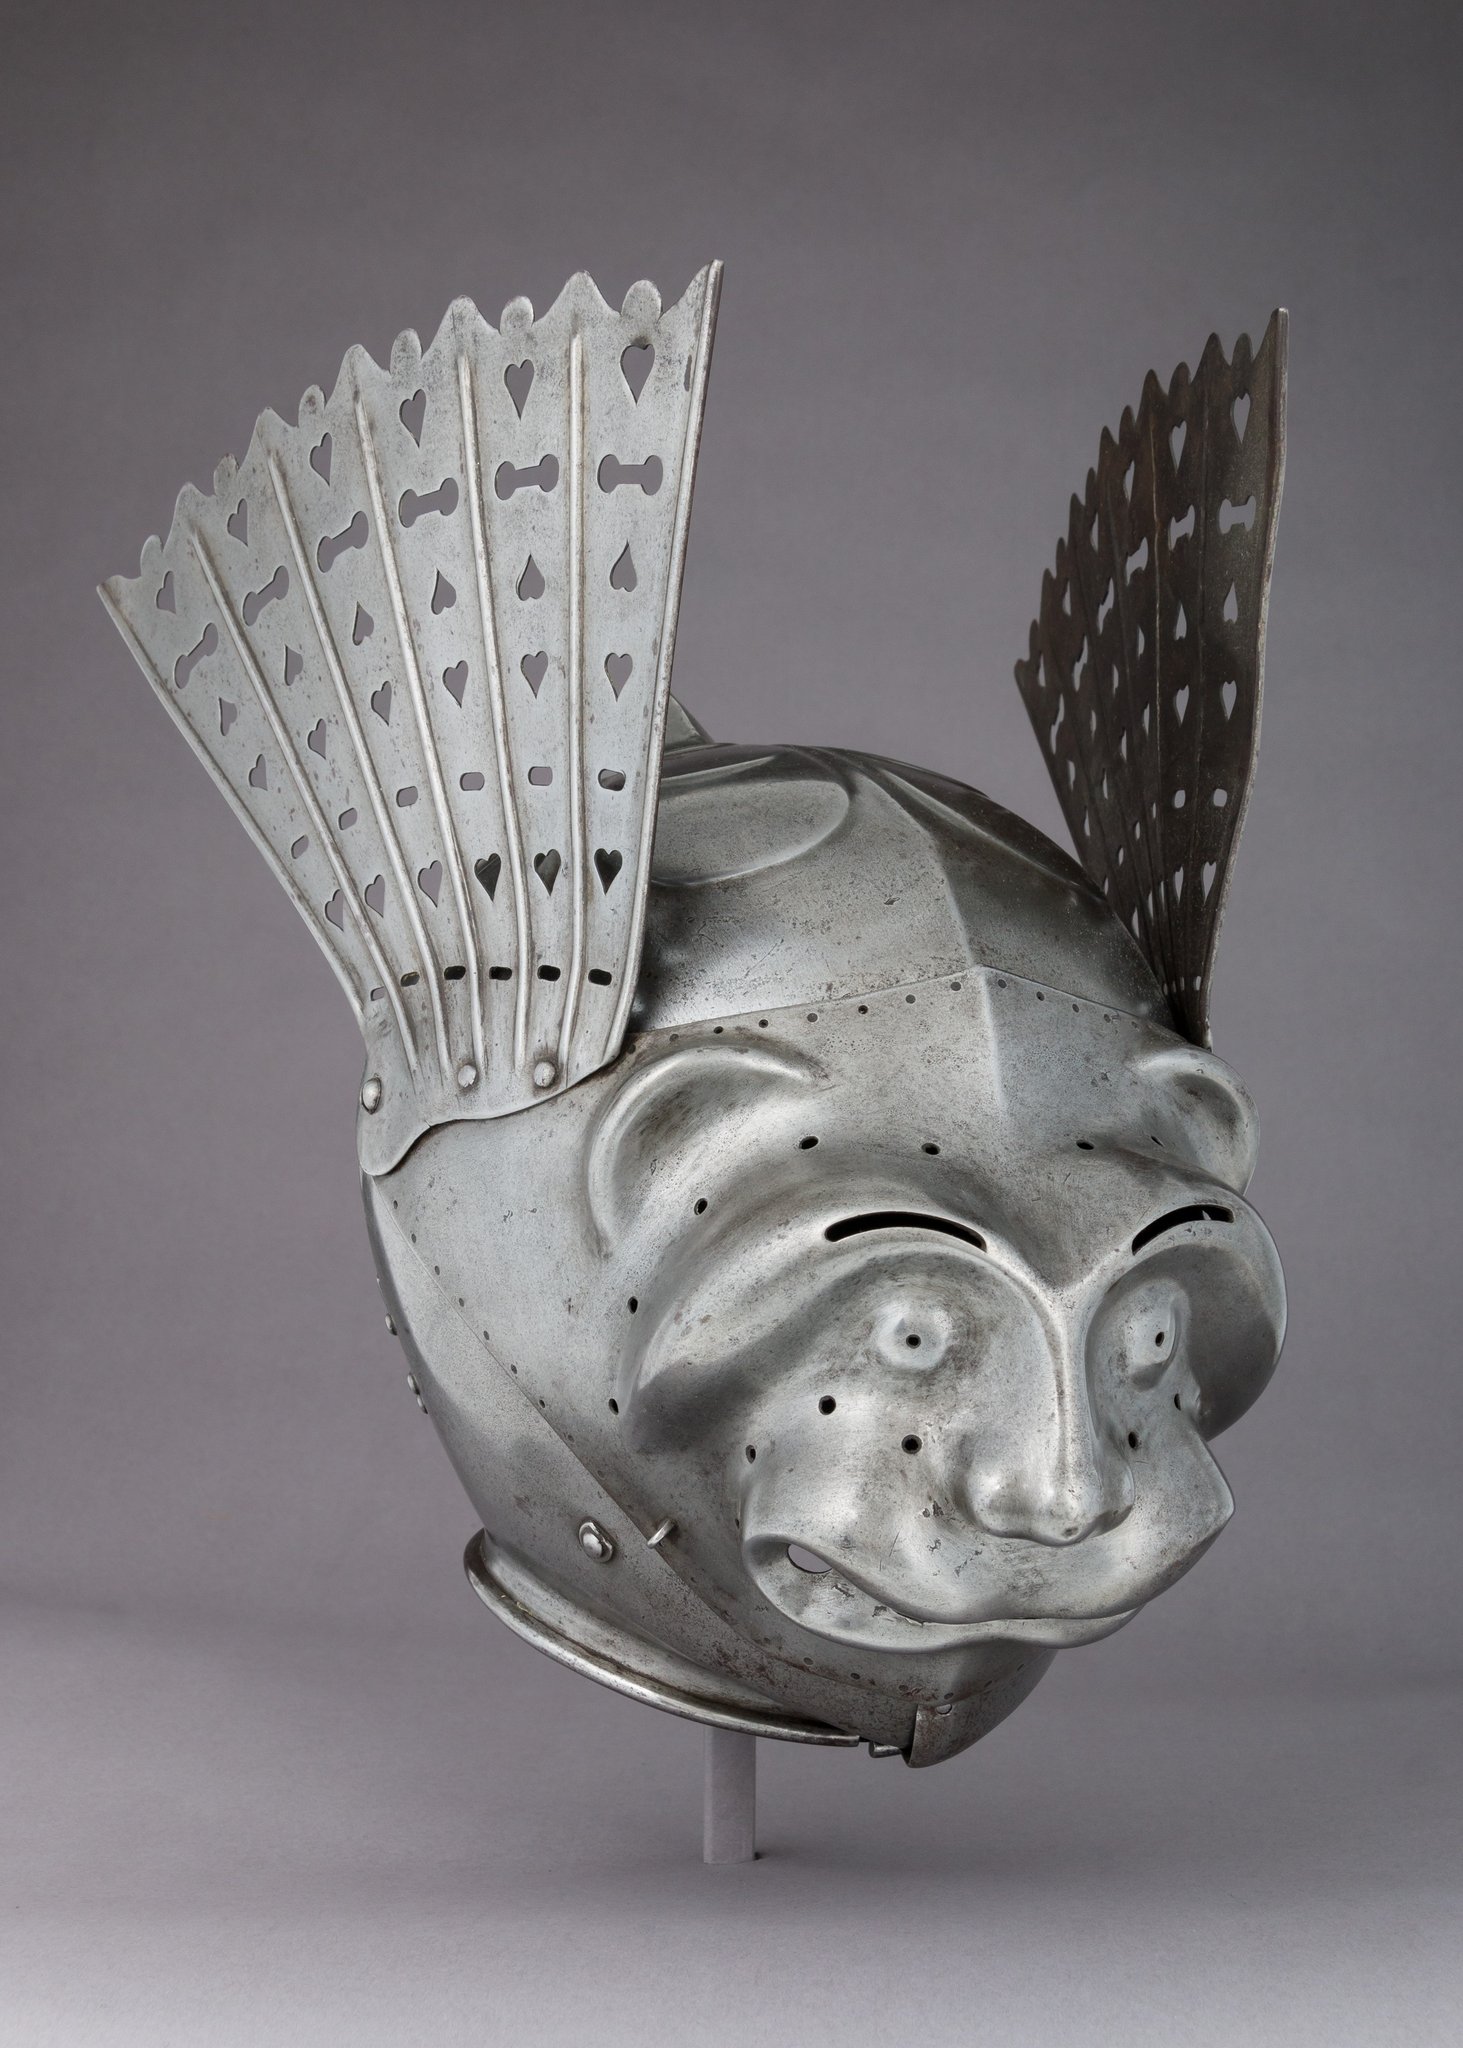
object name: armet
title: Armet-à-Rondelle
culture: polish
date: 1850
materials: steel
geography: poland